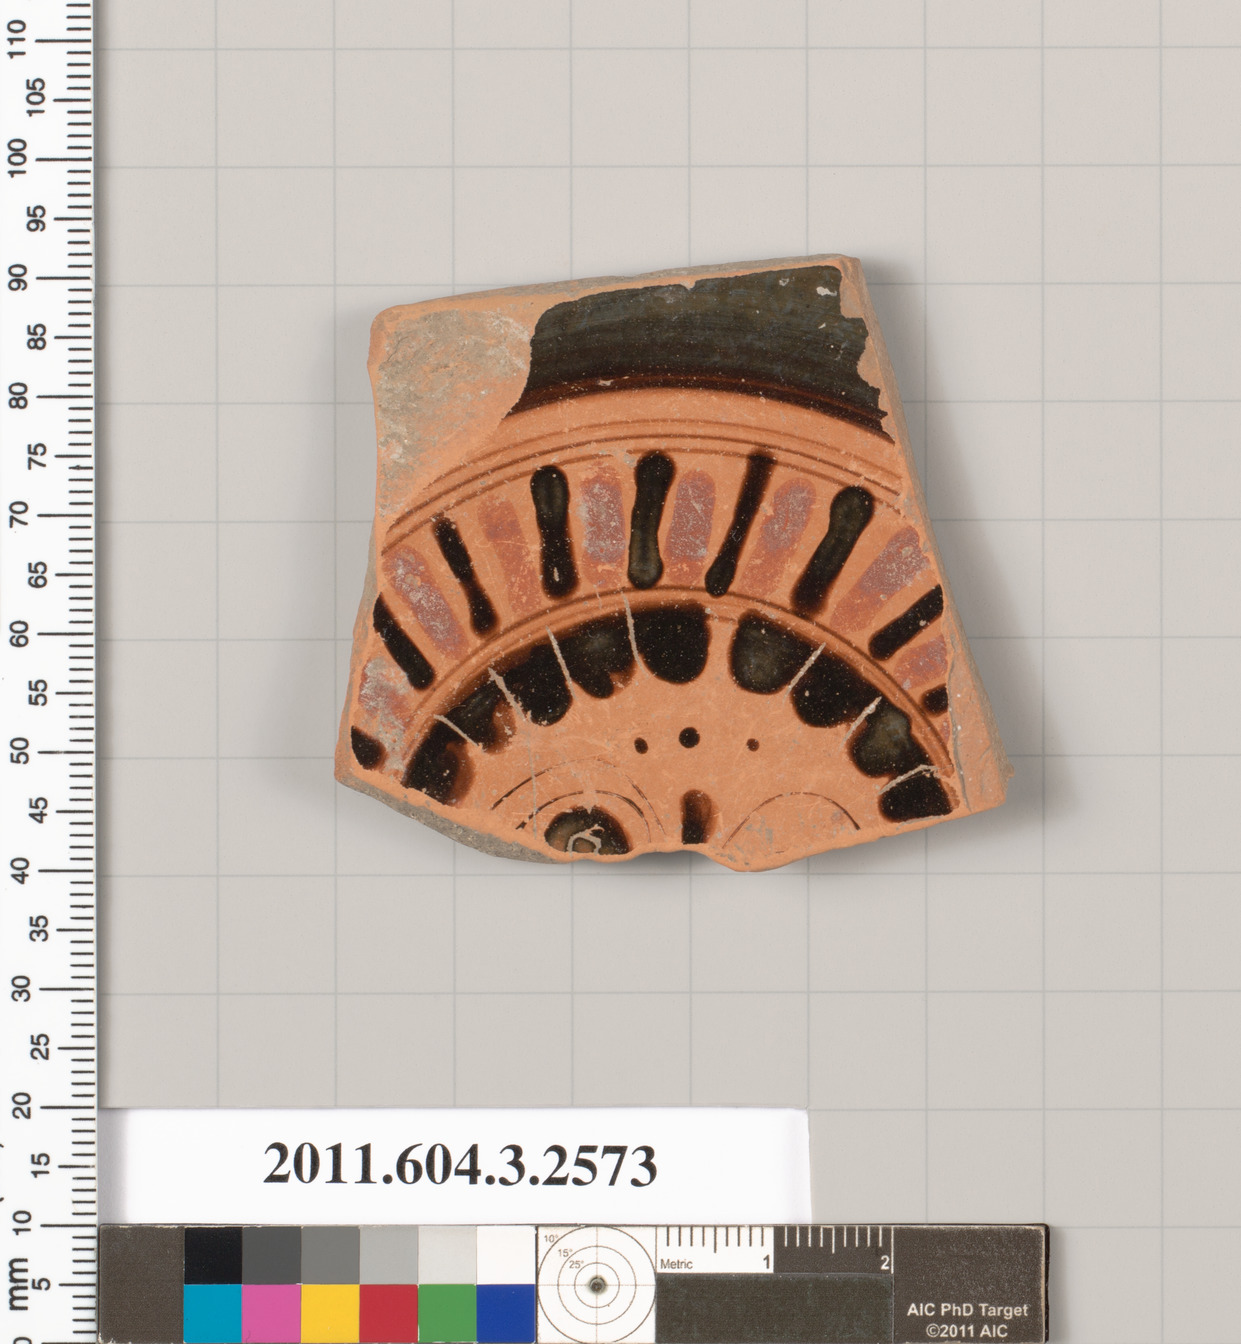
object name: kylix fragment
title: Terracotta fragment of a Little Master cup (drinking cup)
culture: greek, attic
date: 560-530 BCE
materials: terracotta